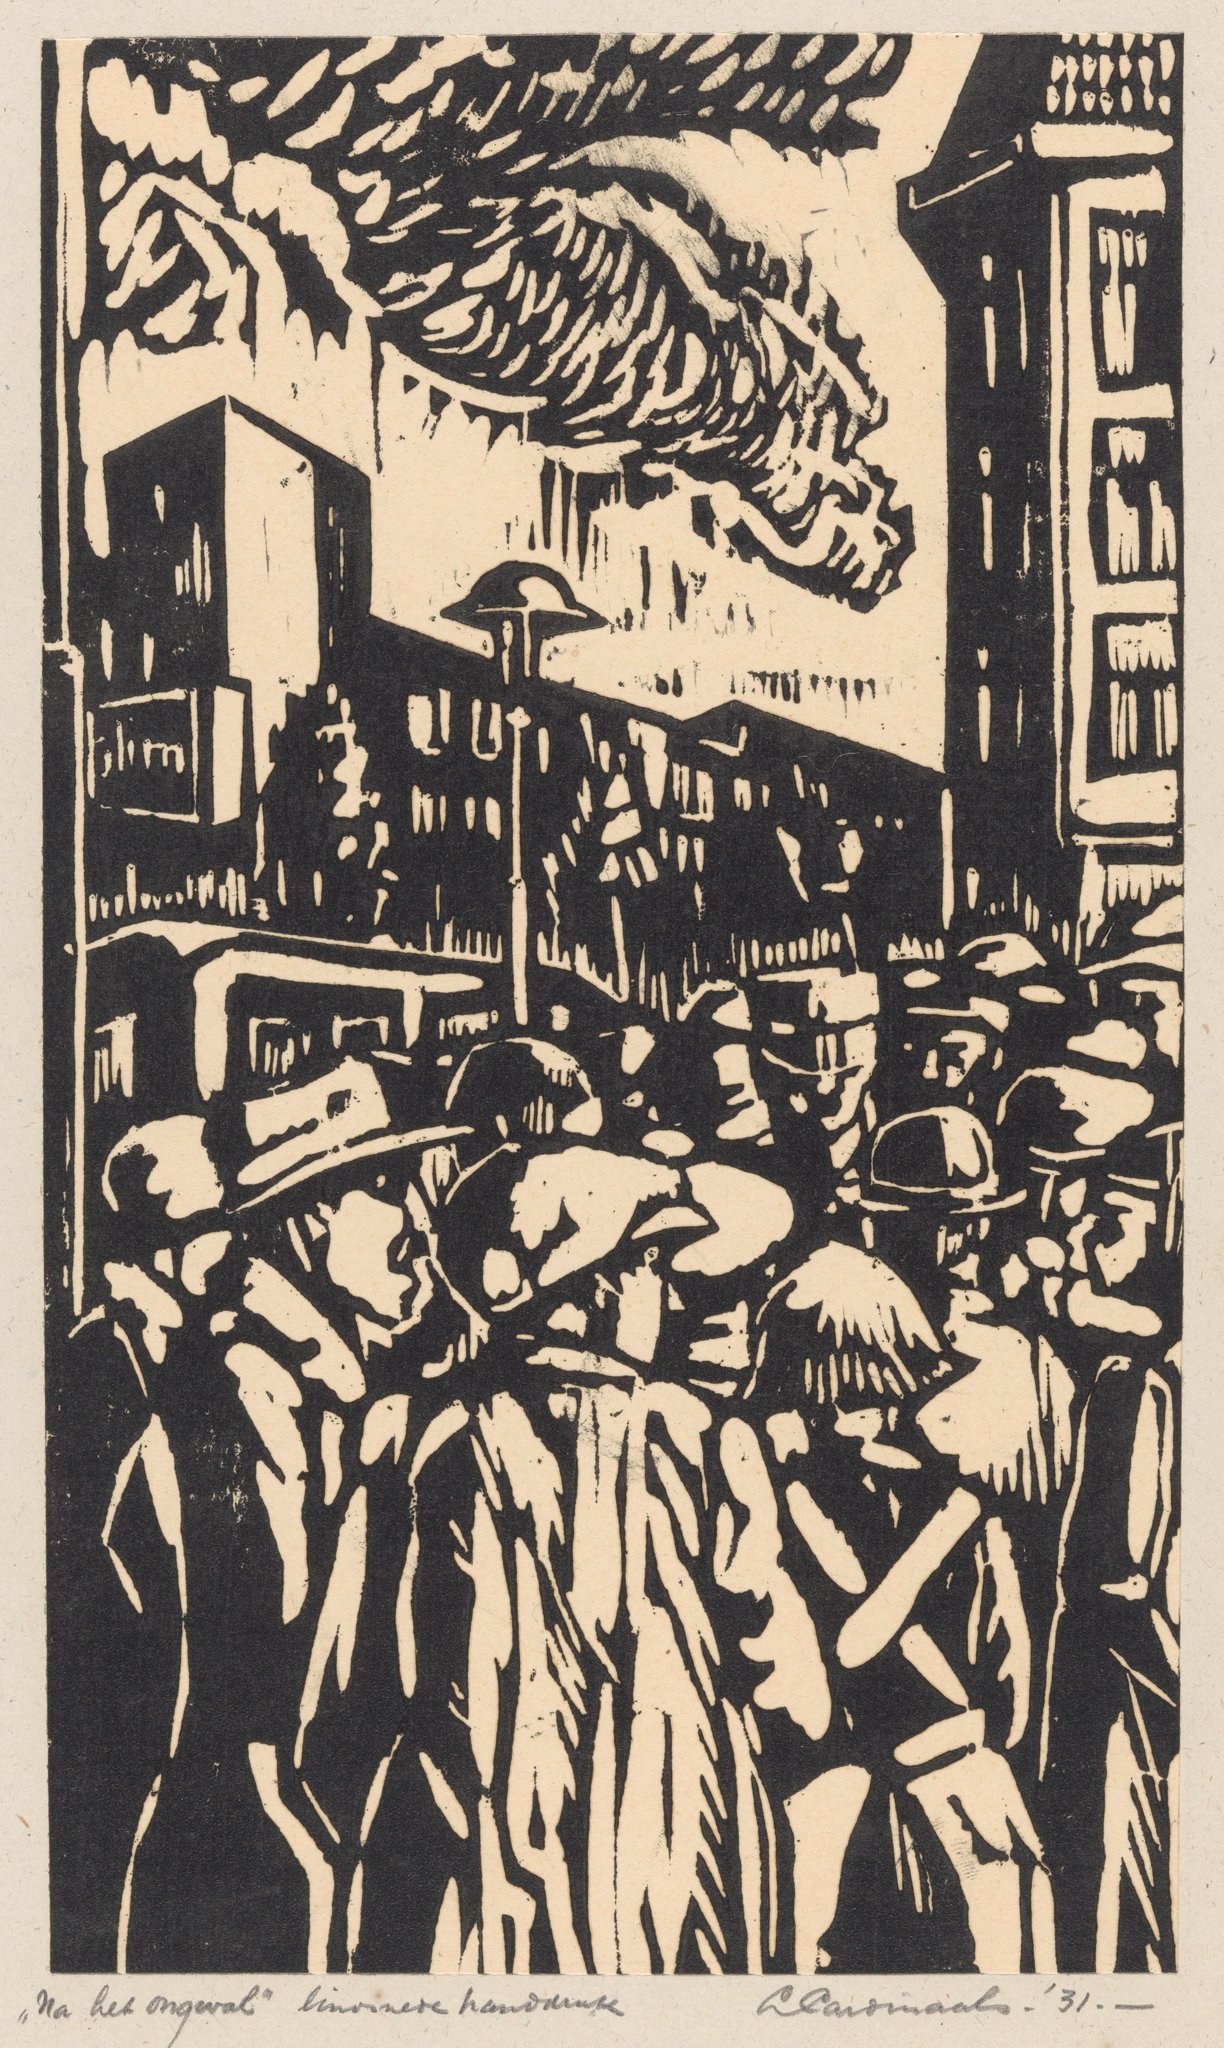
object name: print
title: Na het ongeval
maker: louis cardinaals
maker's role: print maker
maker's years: 1895-1948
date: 1931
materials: paper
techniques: linocut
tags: crowd, mob, street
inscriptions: collector's mark: Lugt 2228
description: Een menigte mensen op straat. Op de achtergrond huizen en een lantaarnpaal.